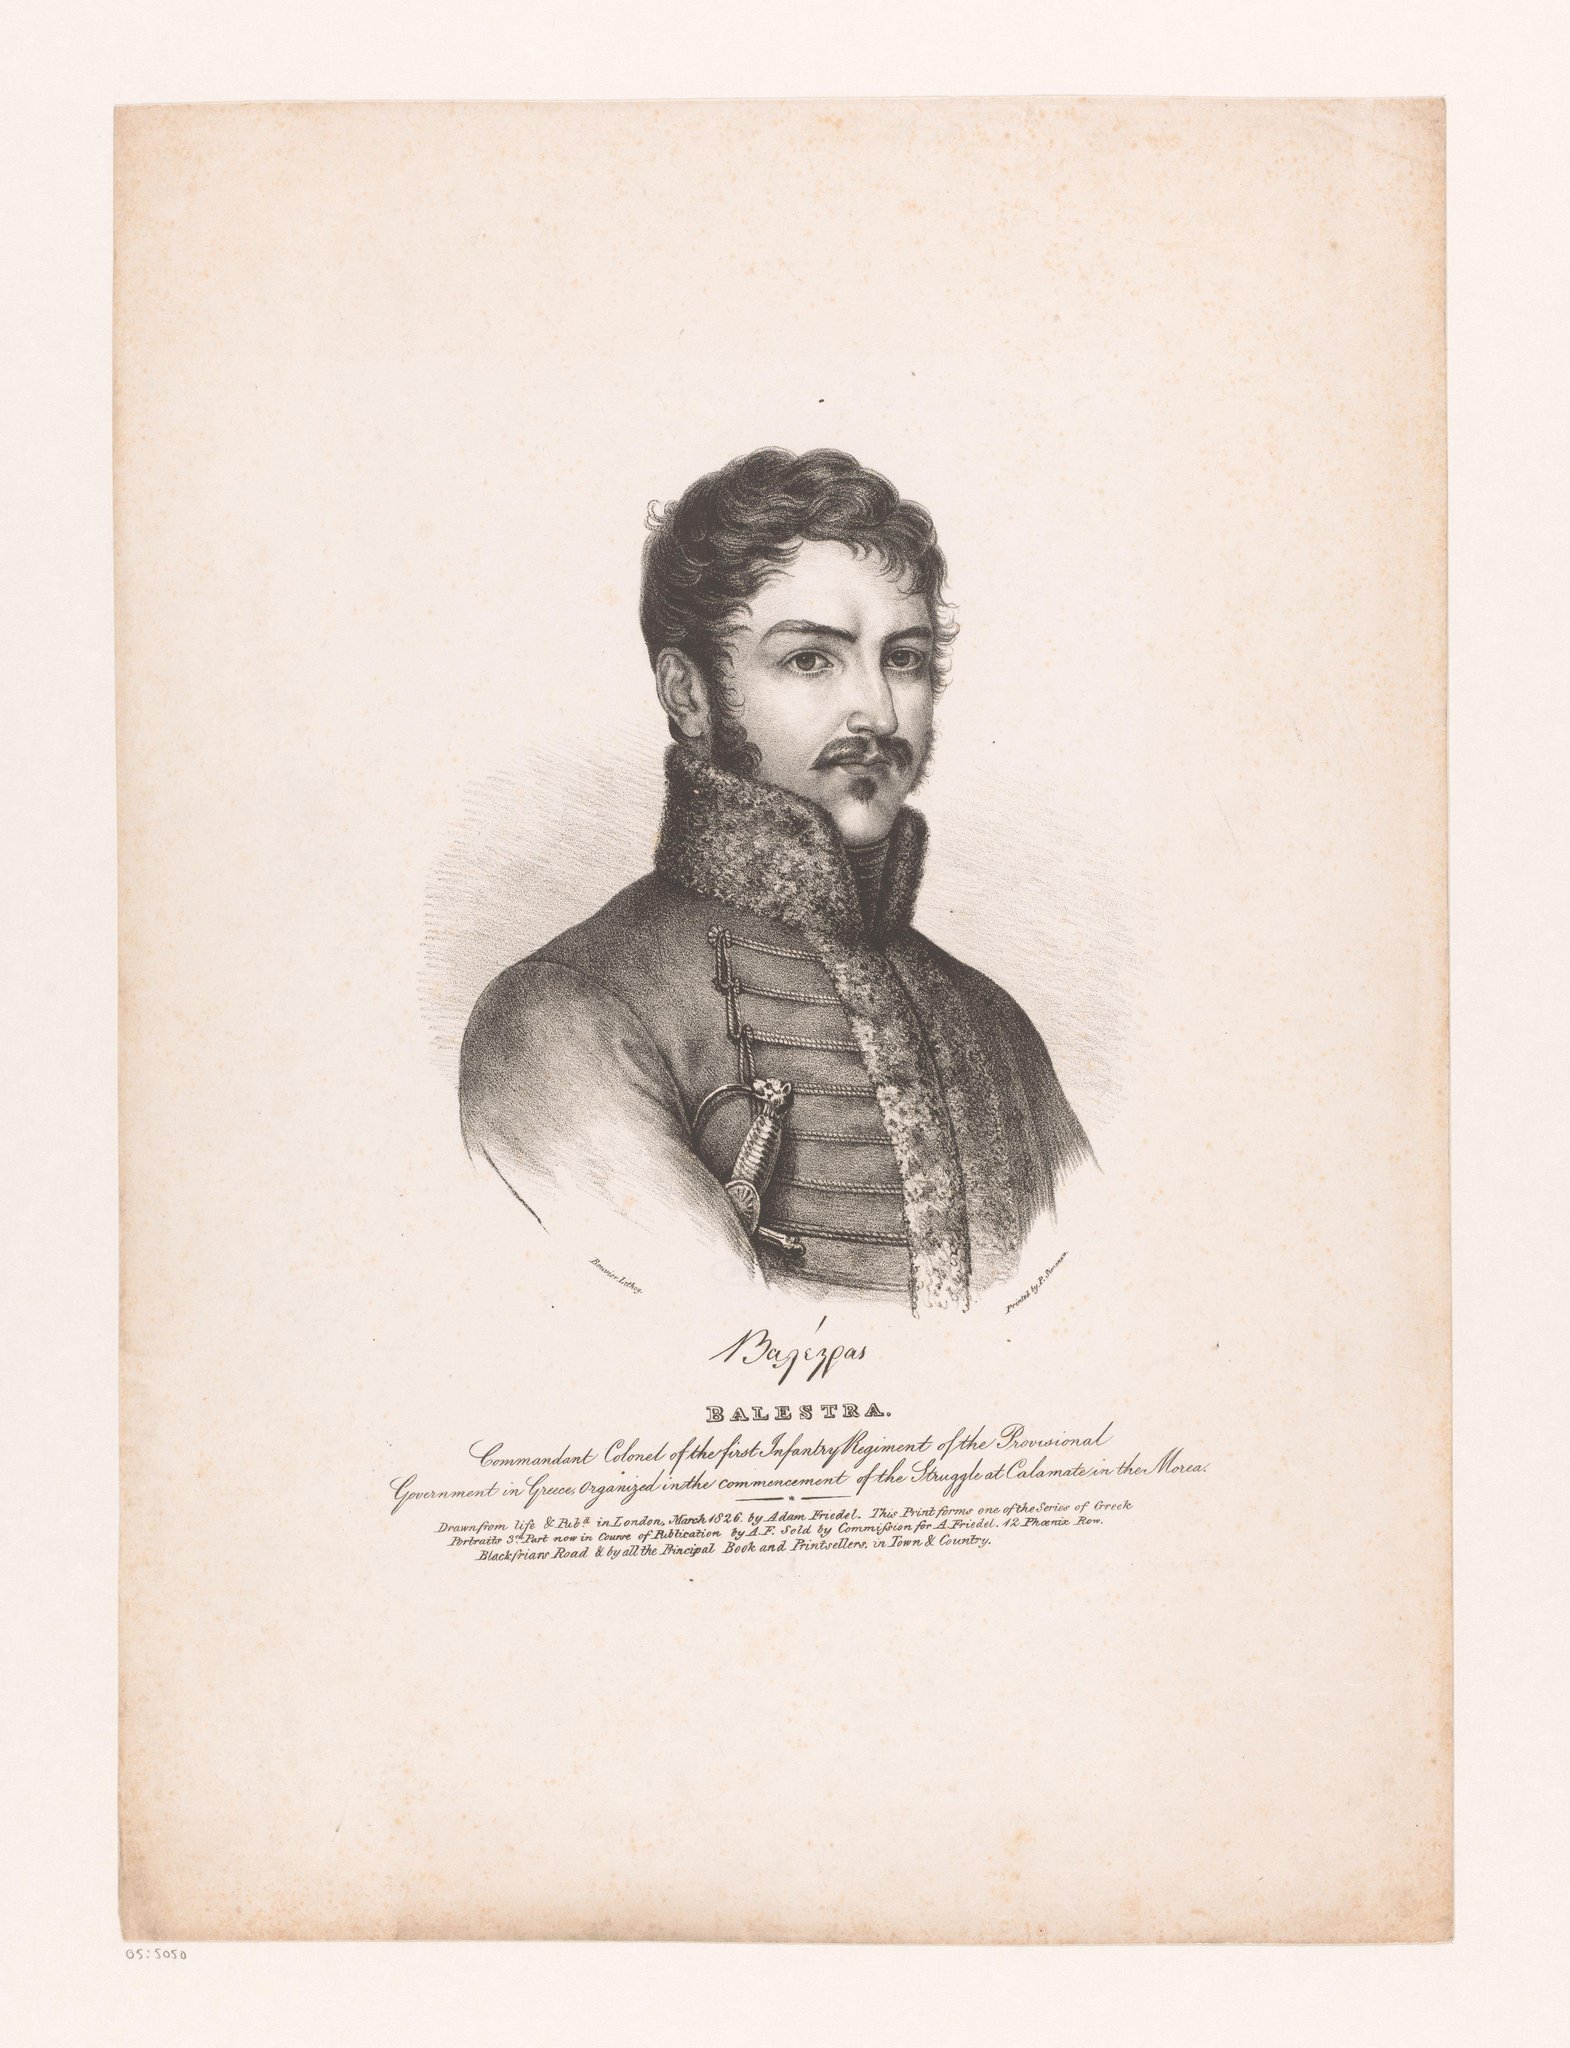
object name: print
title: Balestra. Commandant Colonel of the first Infantry Regiment of the Provisional Government in Greece, organized in the commencement of the Struggle at Calamate in the Morea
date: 1826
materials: paper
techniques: lithograph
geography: london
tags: adult man, historical persons, beard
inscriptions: collector's mark: Lugt 2228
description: Prent maakt onderdeel uit van een serie portretten van figuren betrokken bij de Griekse onafhankelijkheidsoorlog. Deze serie is uitgegeven door Adam Friedel in verschillende delen en edities.